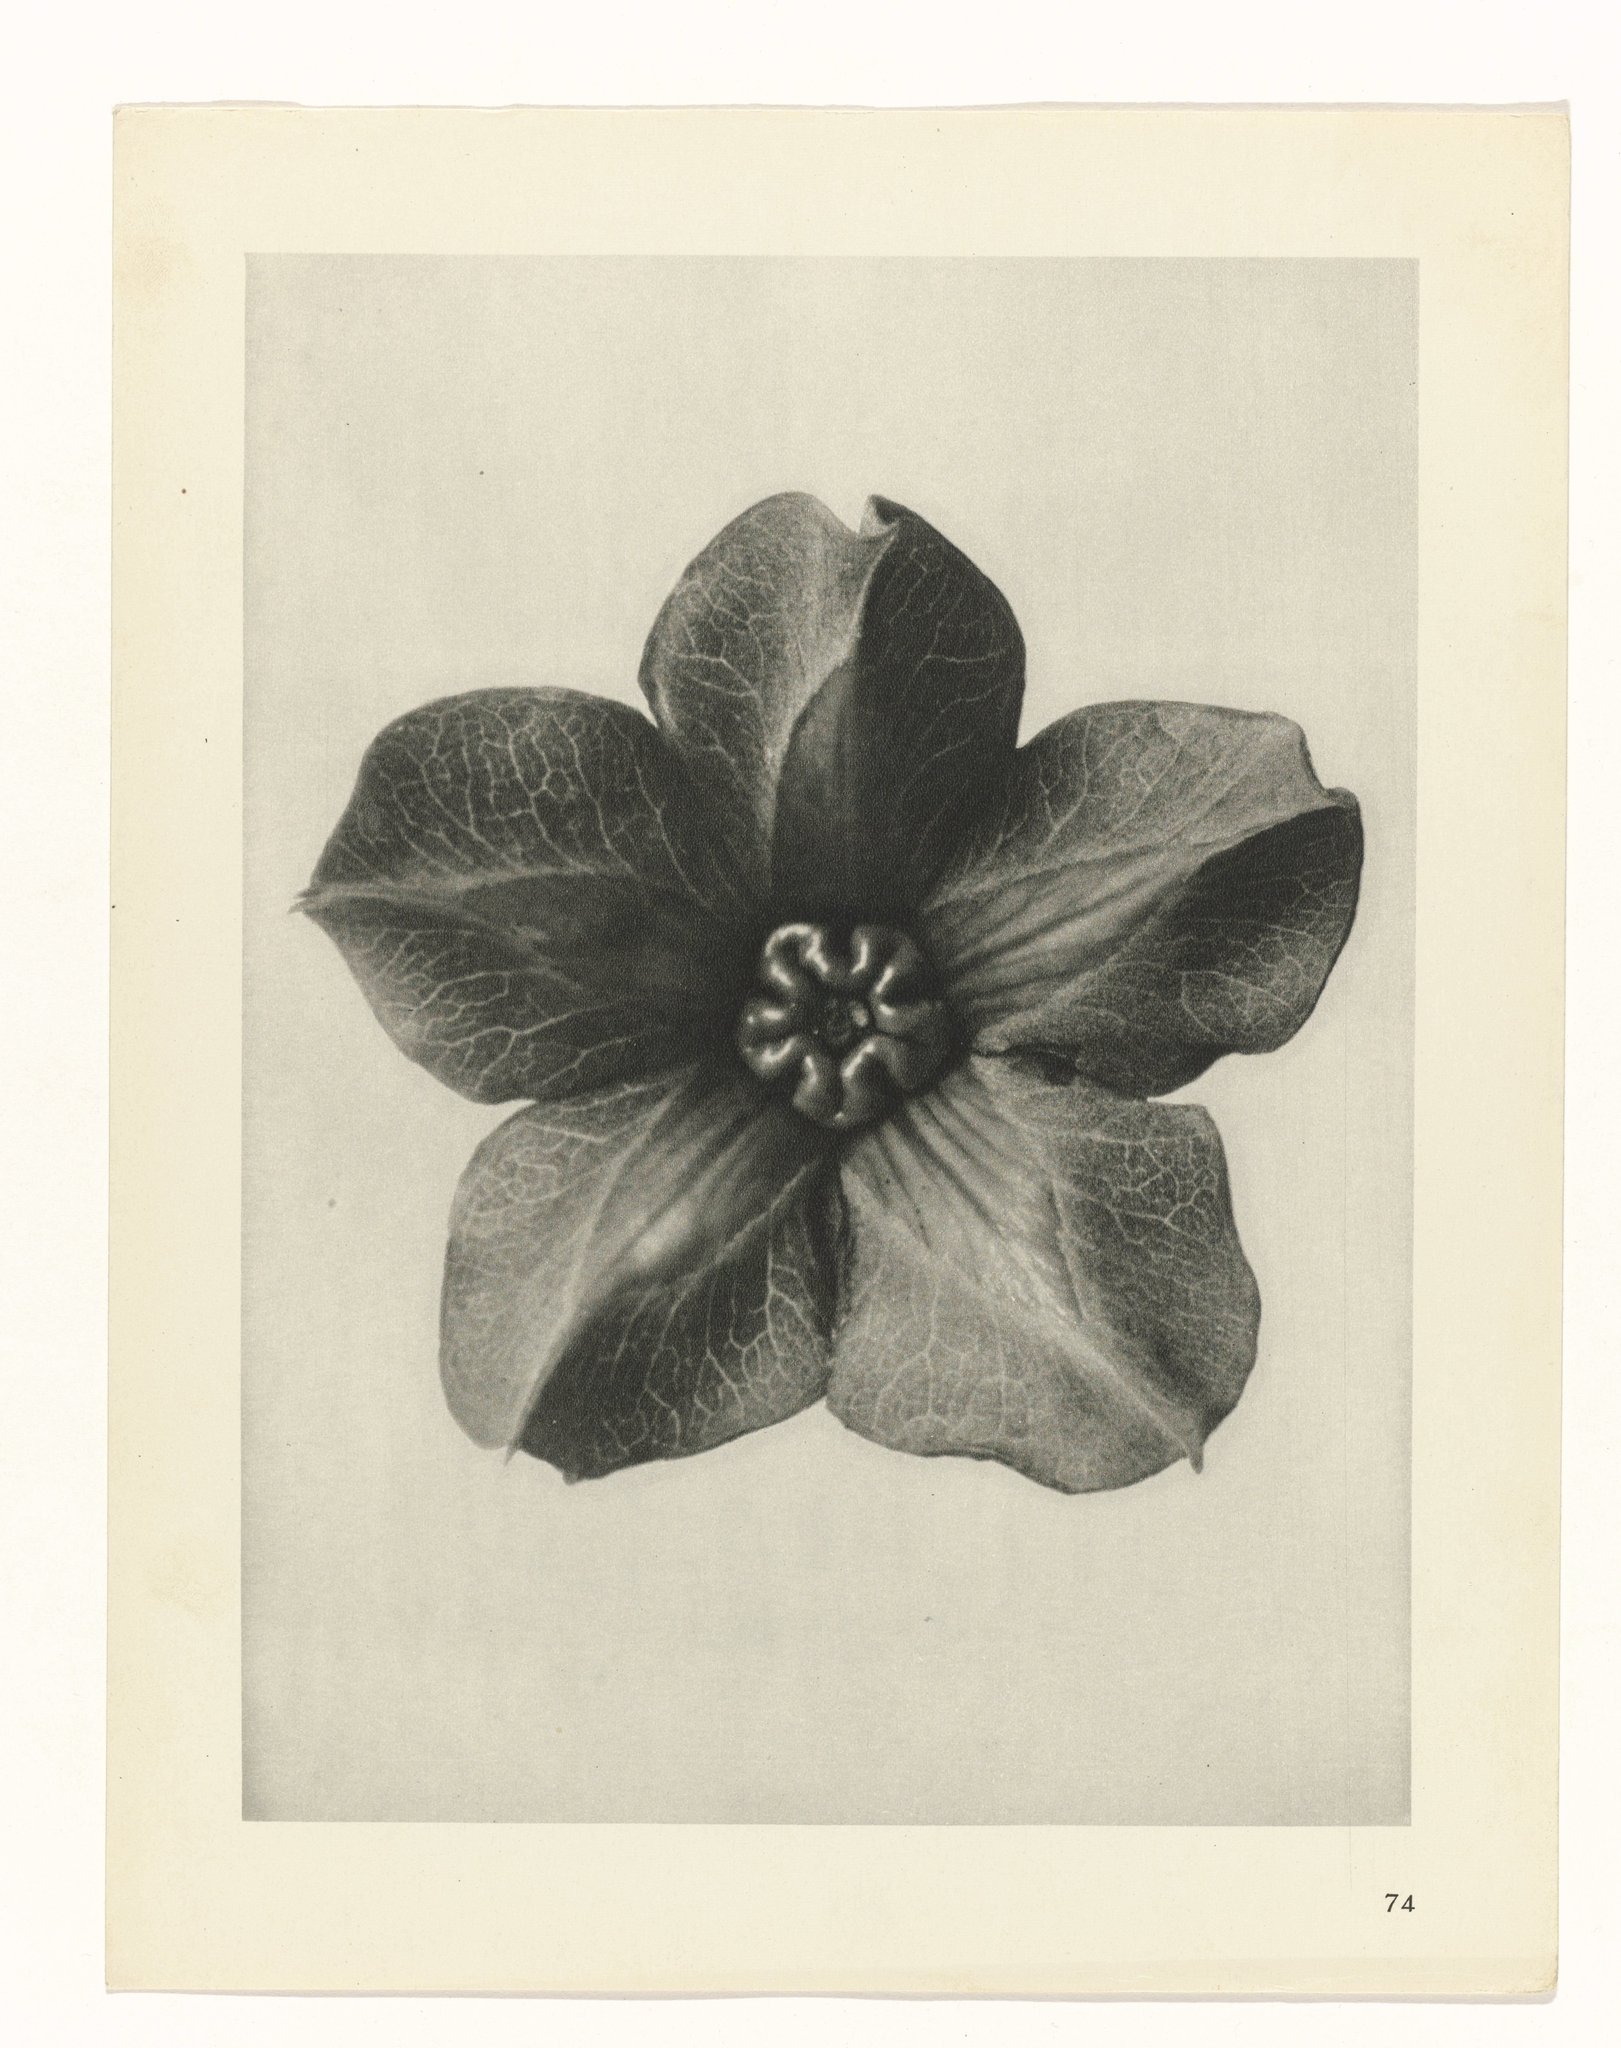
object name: photograph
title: Plantstudie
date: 1928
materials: ink, paper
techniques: rotogravure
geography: berlin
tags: plants (in general)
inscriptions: number: ‘74’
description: facher Vergrößerung. Afkomstig uit losbladige uitgave.